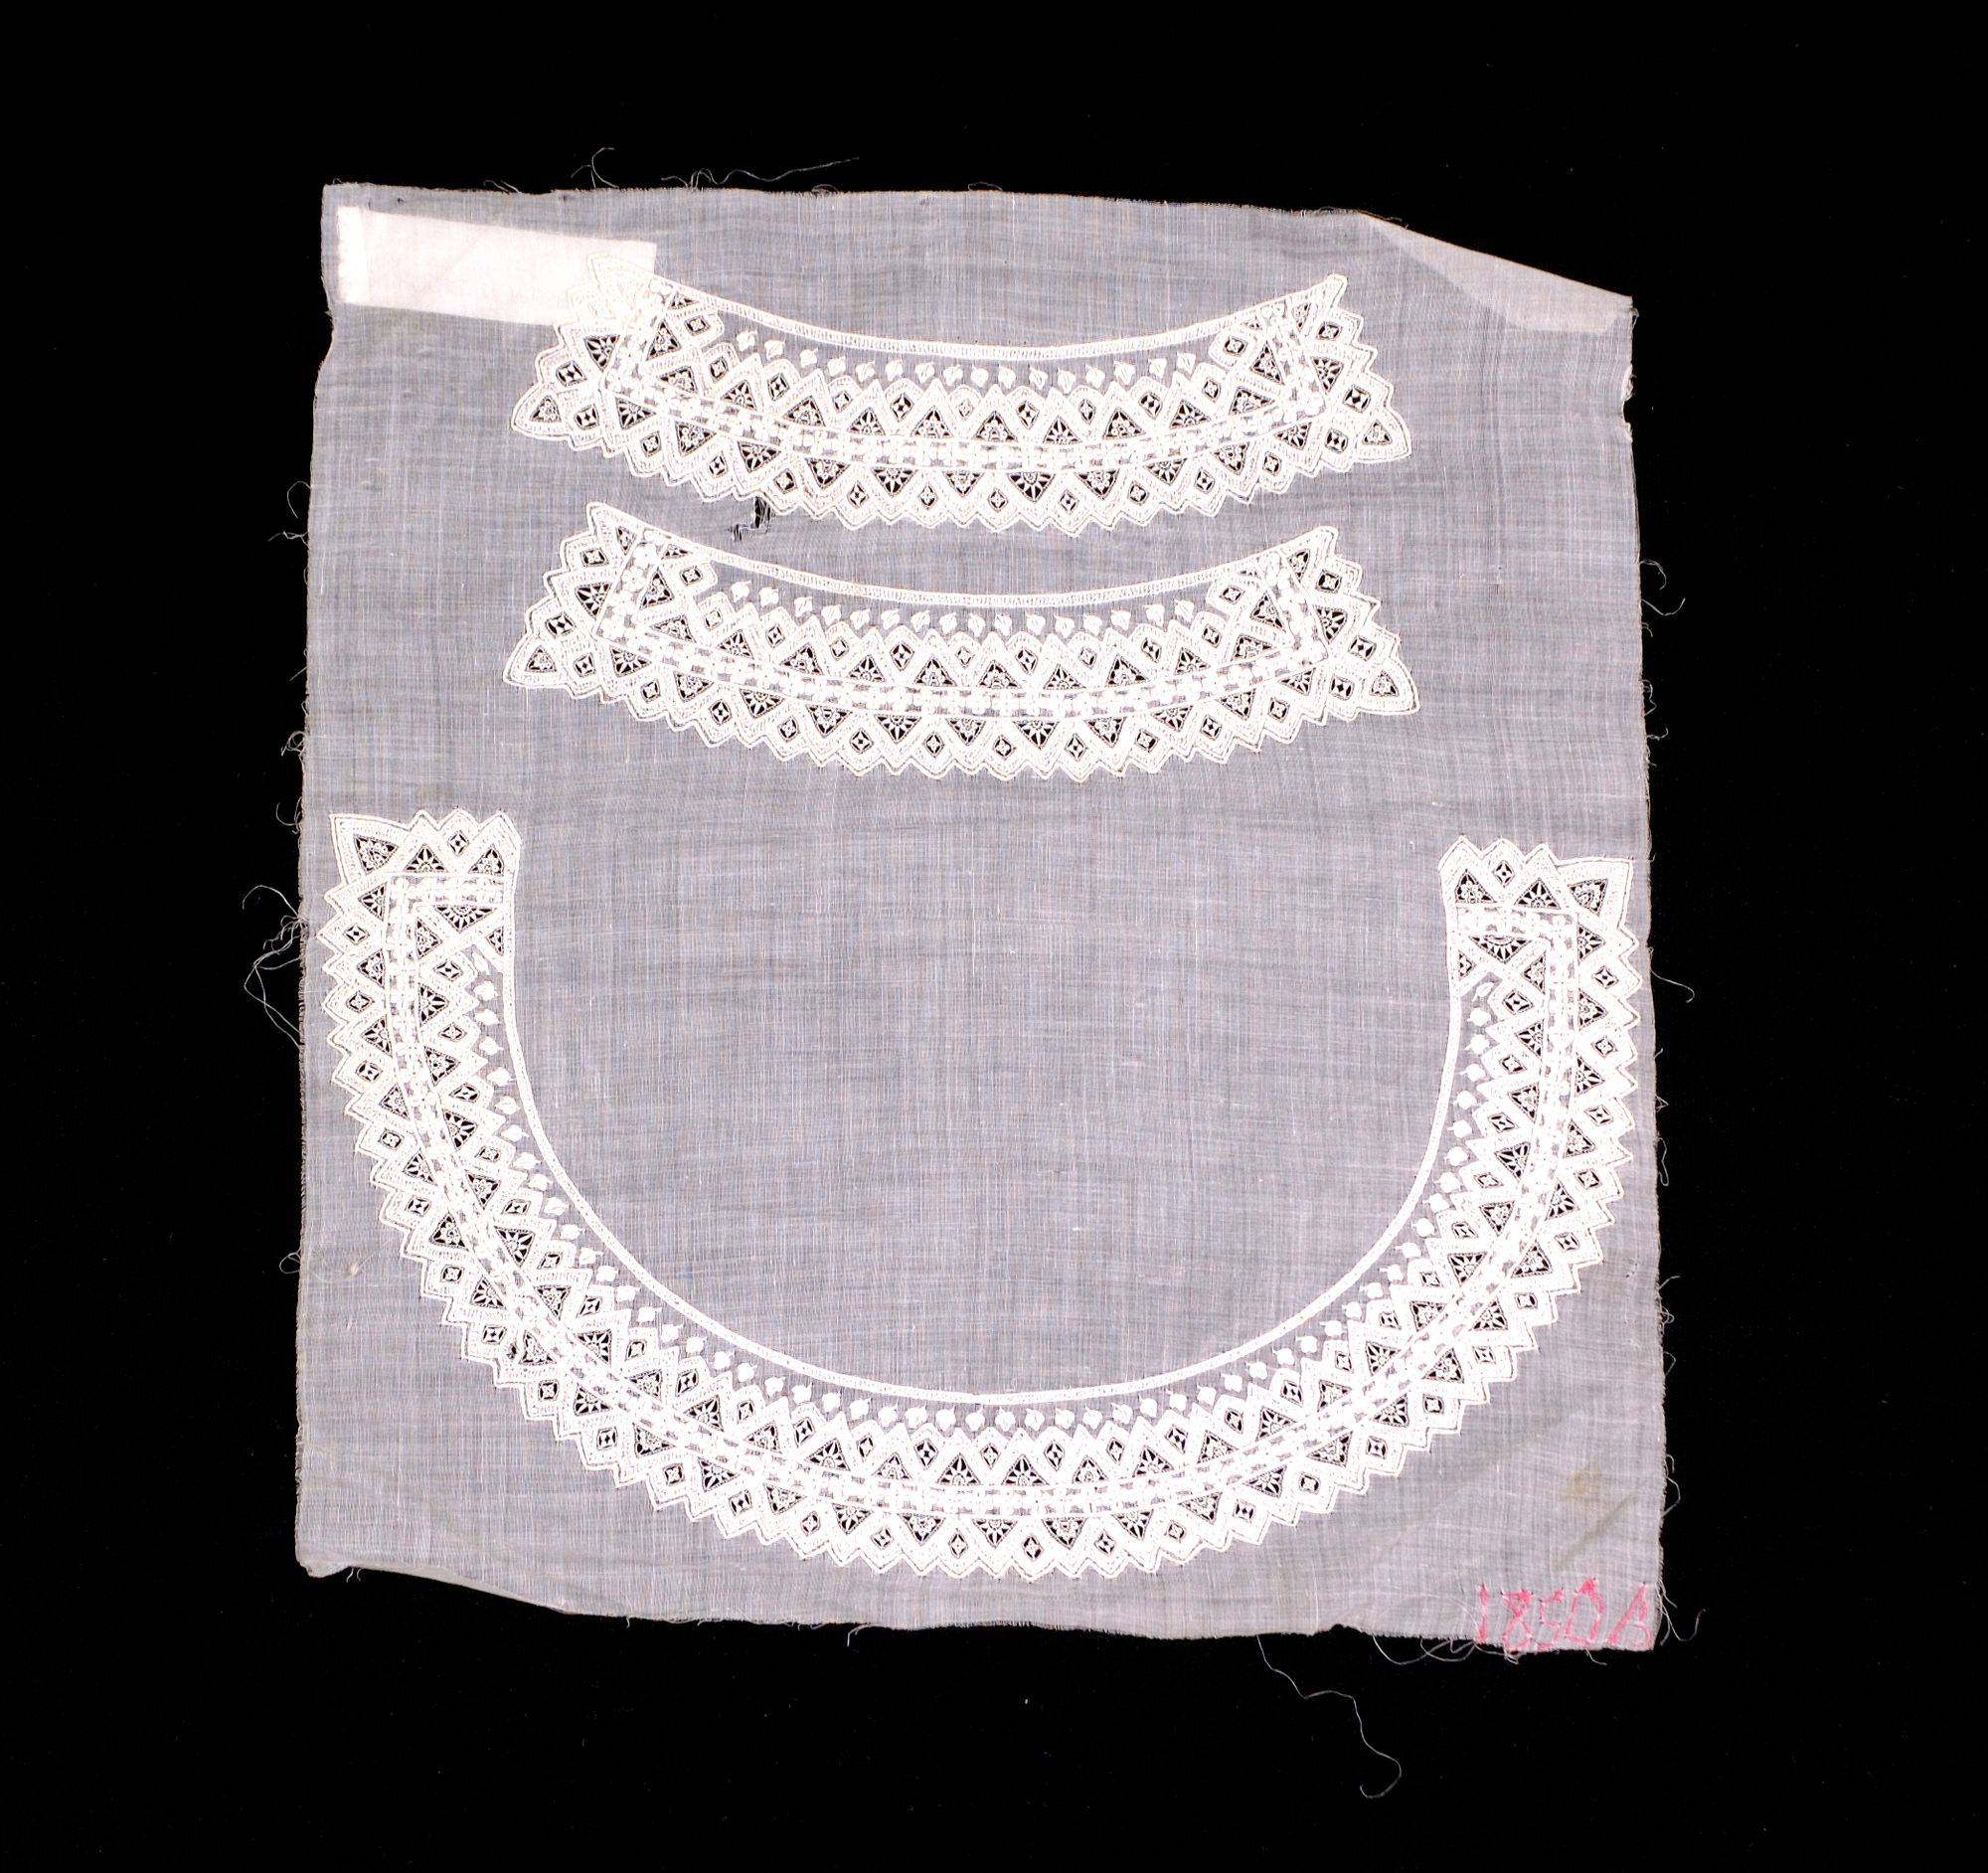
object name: accessory set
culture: french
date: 1850-1860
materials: linen